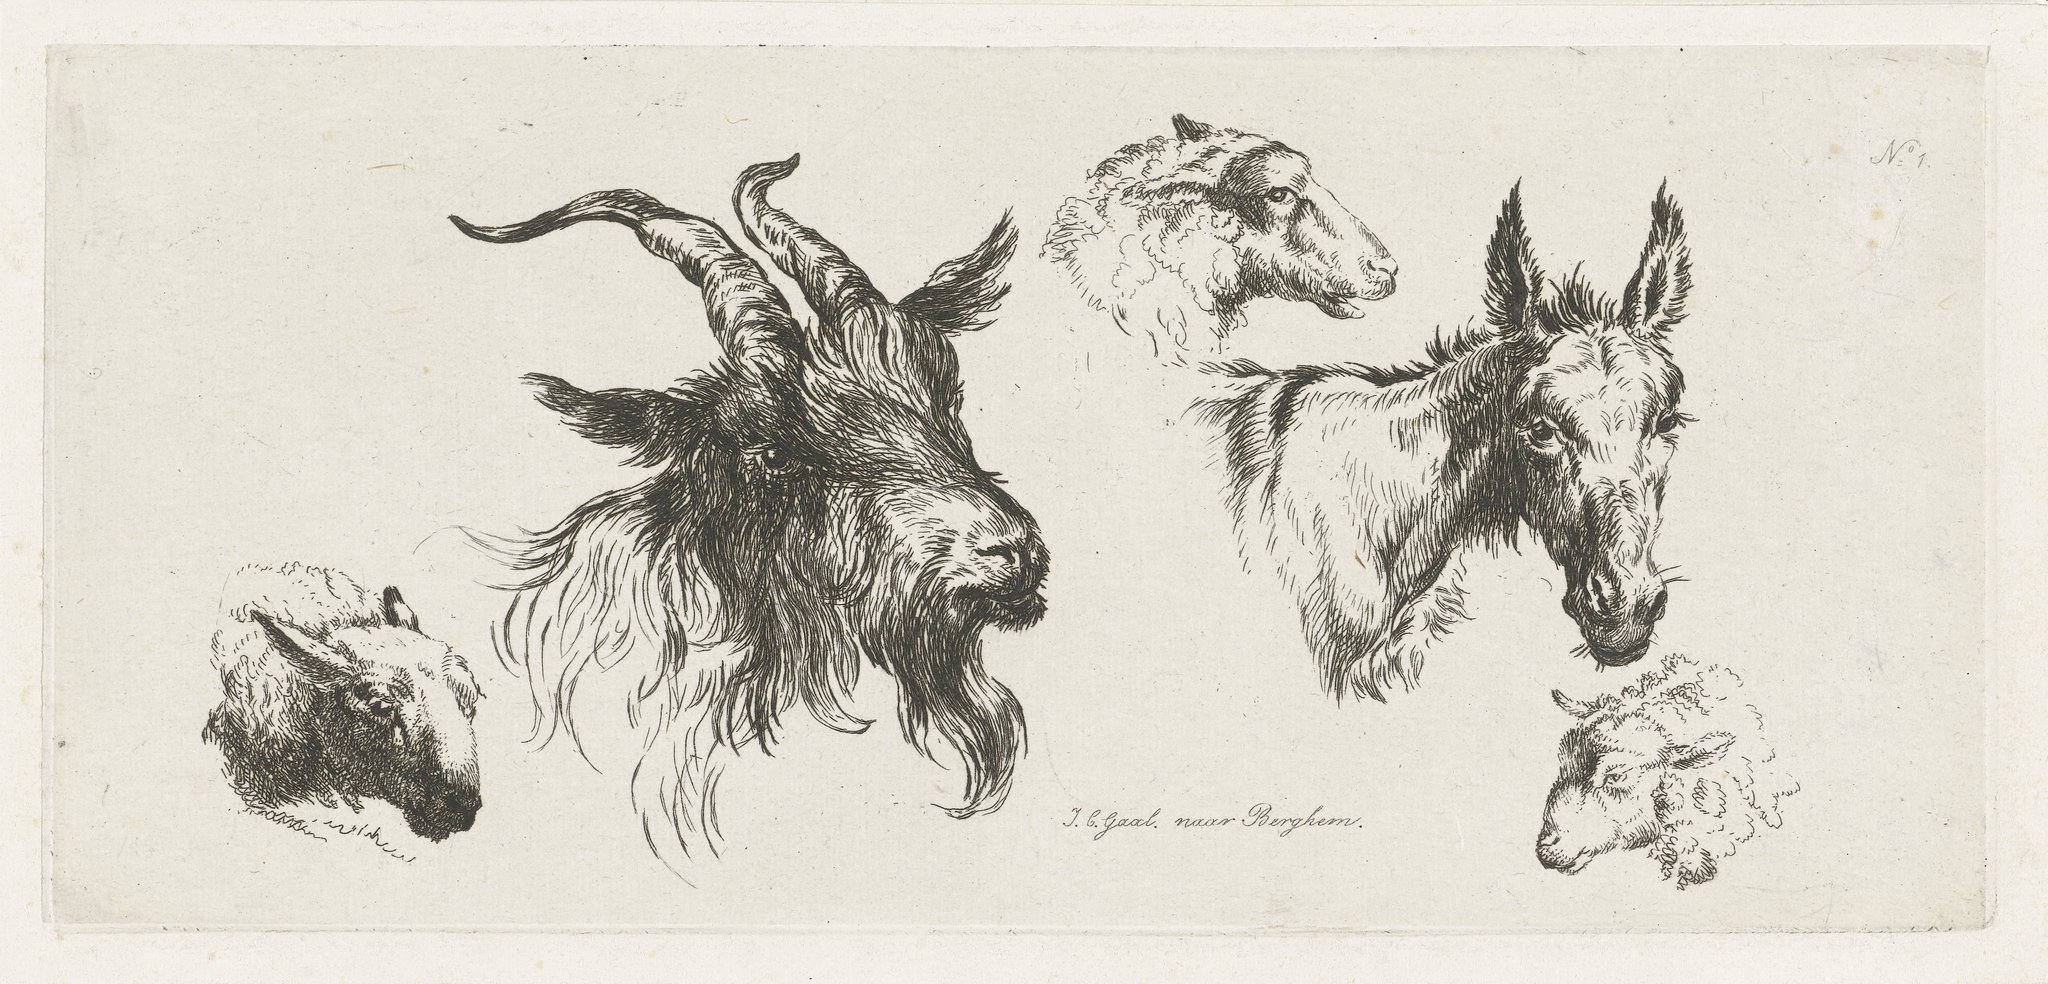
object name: print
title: Studieblad met dierenkoppen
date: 1850-1855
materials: paper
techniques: etching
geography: netherlands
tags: cattle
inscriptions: collector's mark: Lugt 2228